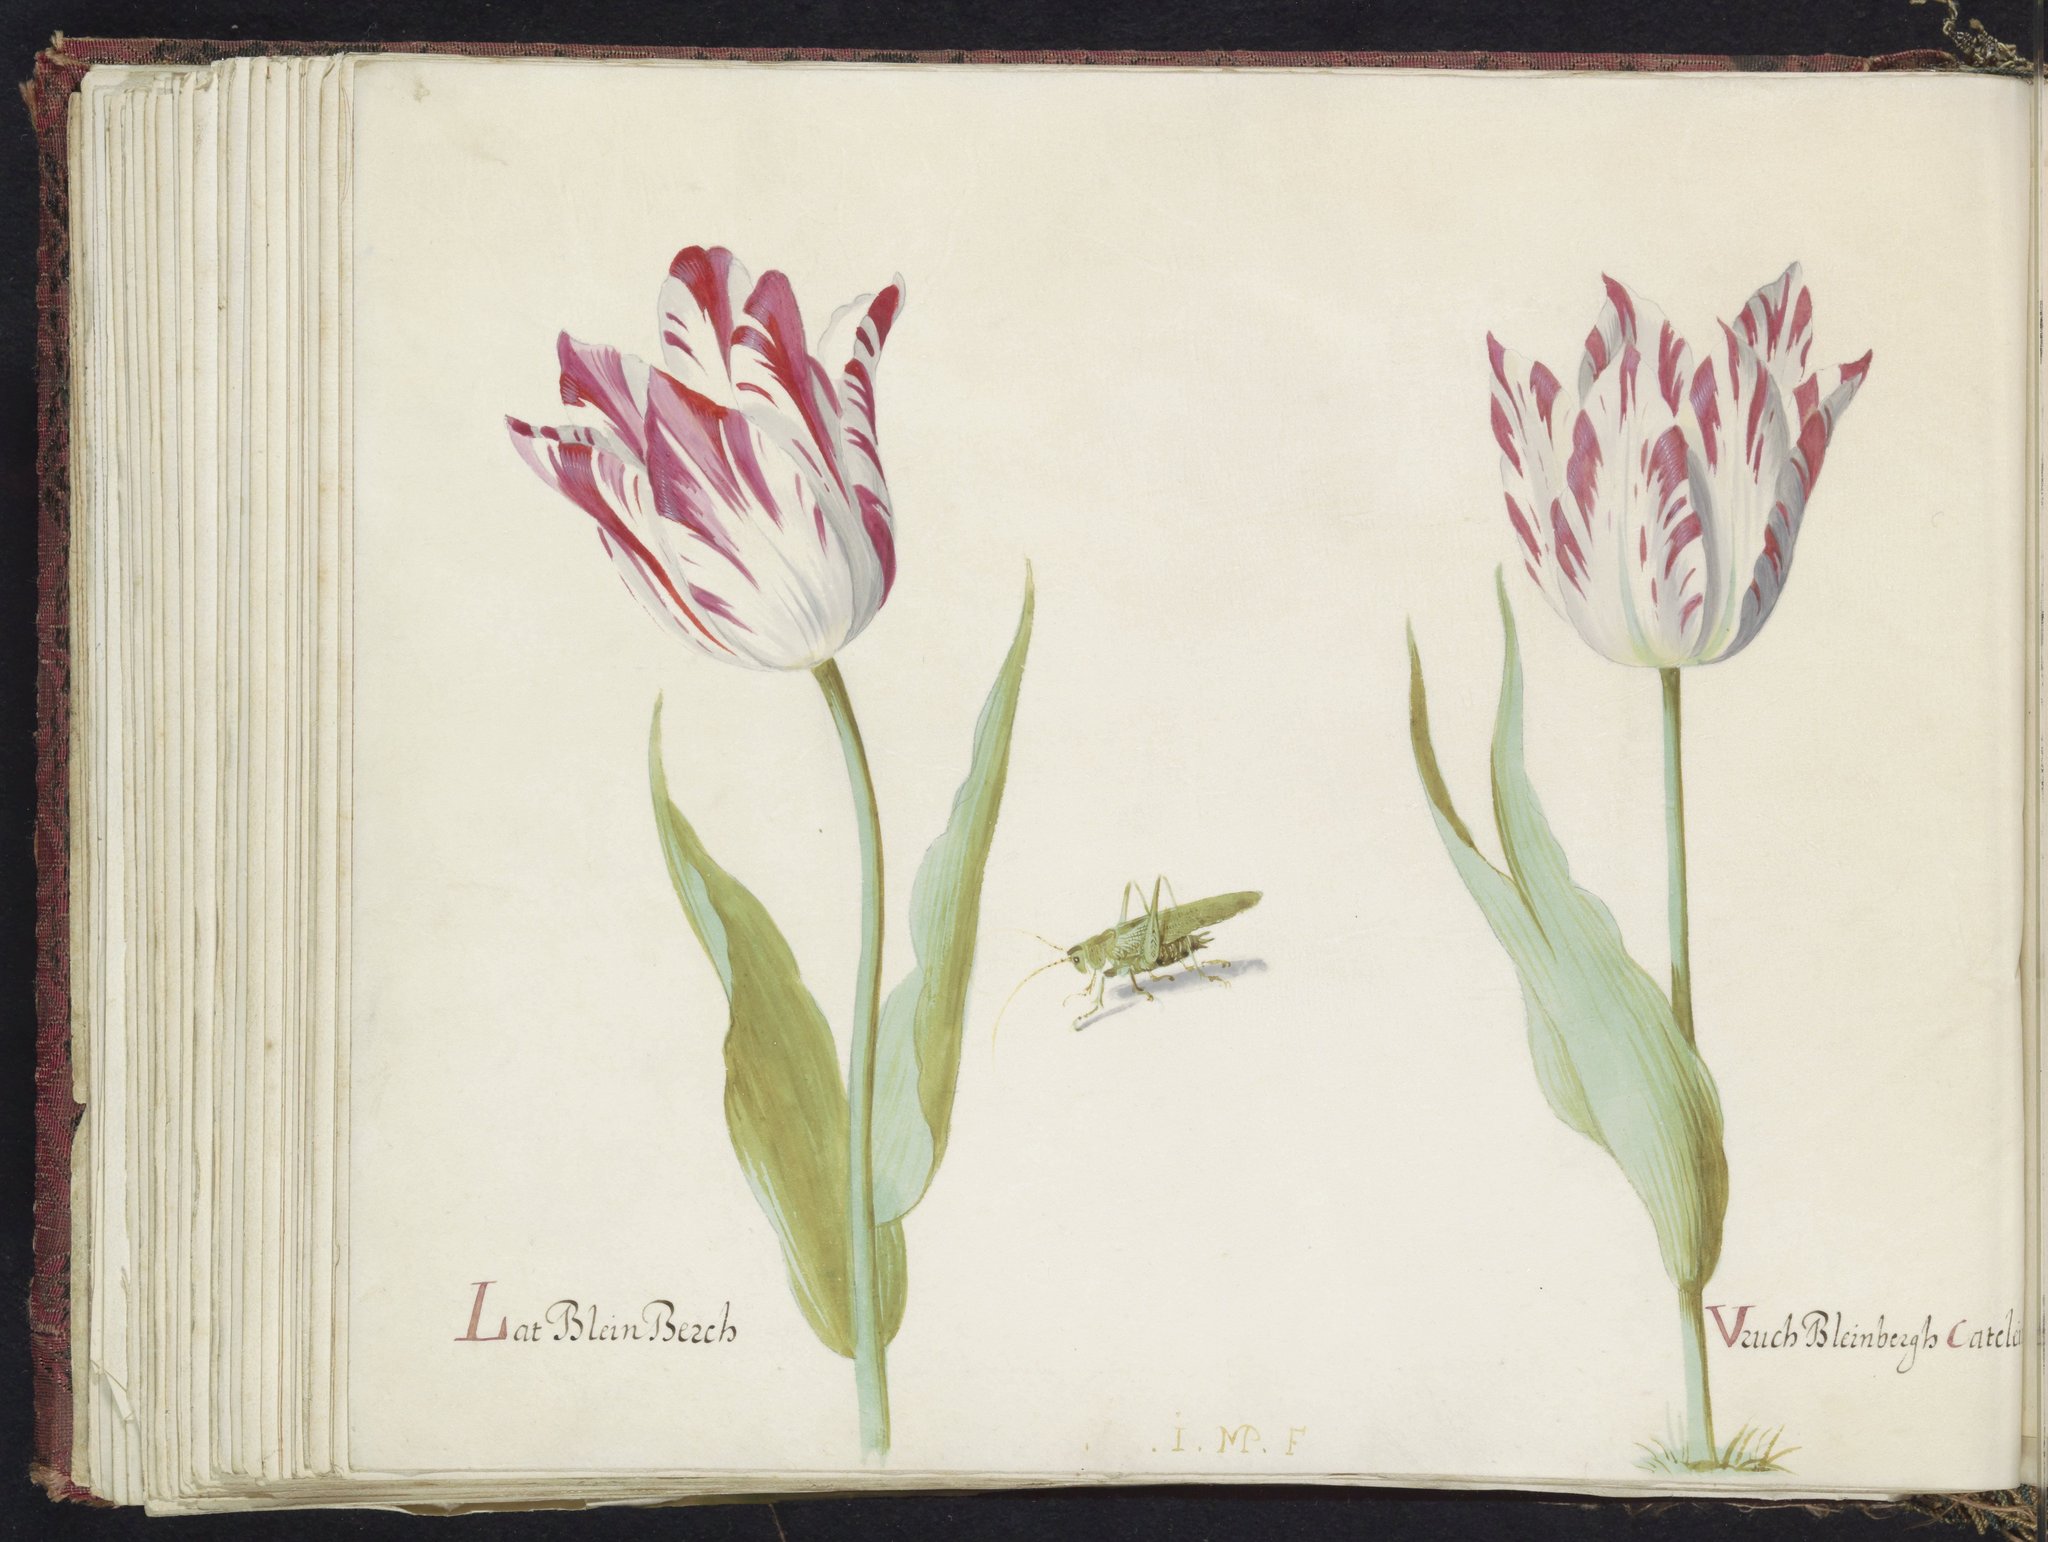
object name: drawing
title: Twee tulpen met sprinkhaan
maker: jacob marrel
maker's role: draughtsman, painter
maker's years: 1614-1681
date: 1637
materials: paint, parchment, pencil, watercolor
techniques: brush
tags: flowers: tulip, insects: grass-hopper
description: De tekening maakt deel uit van een album.